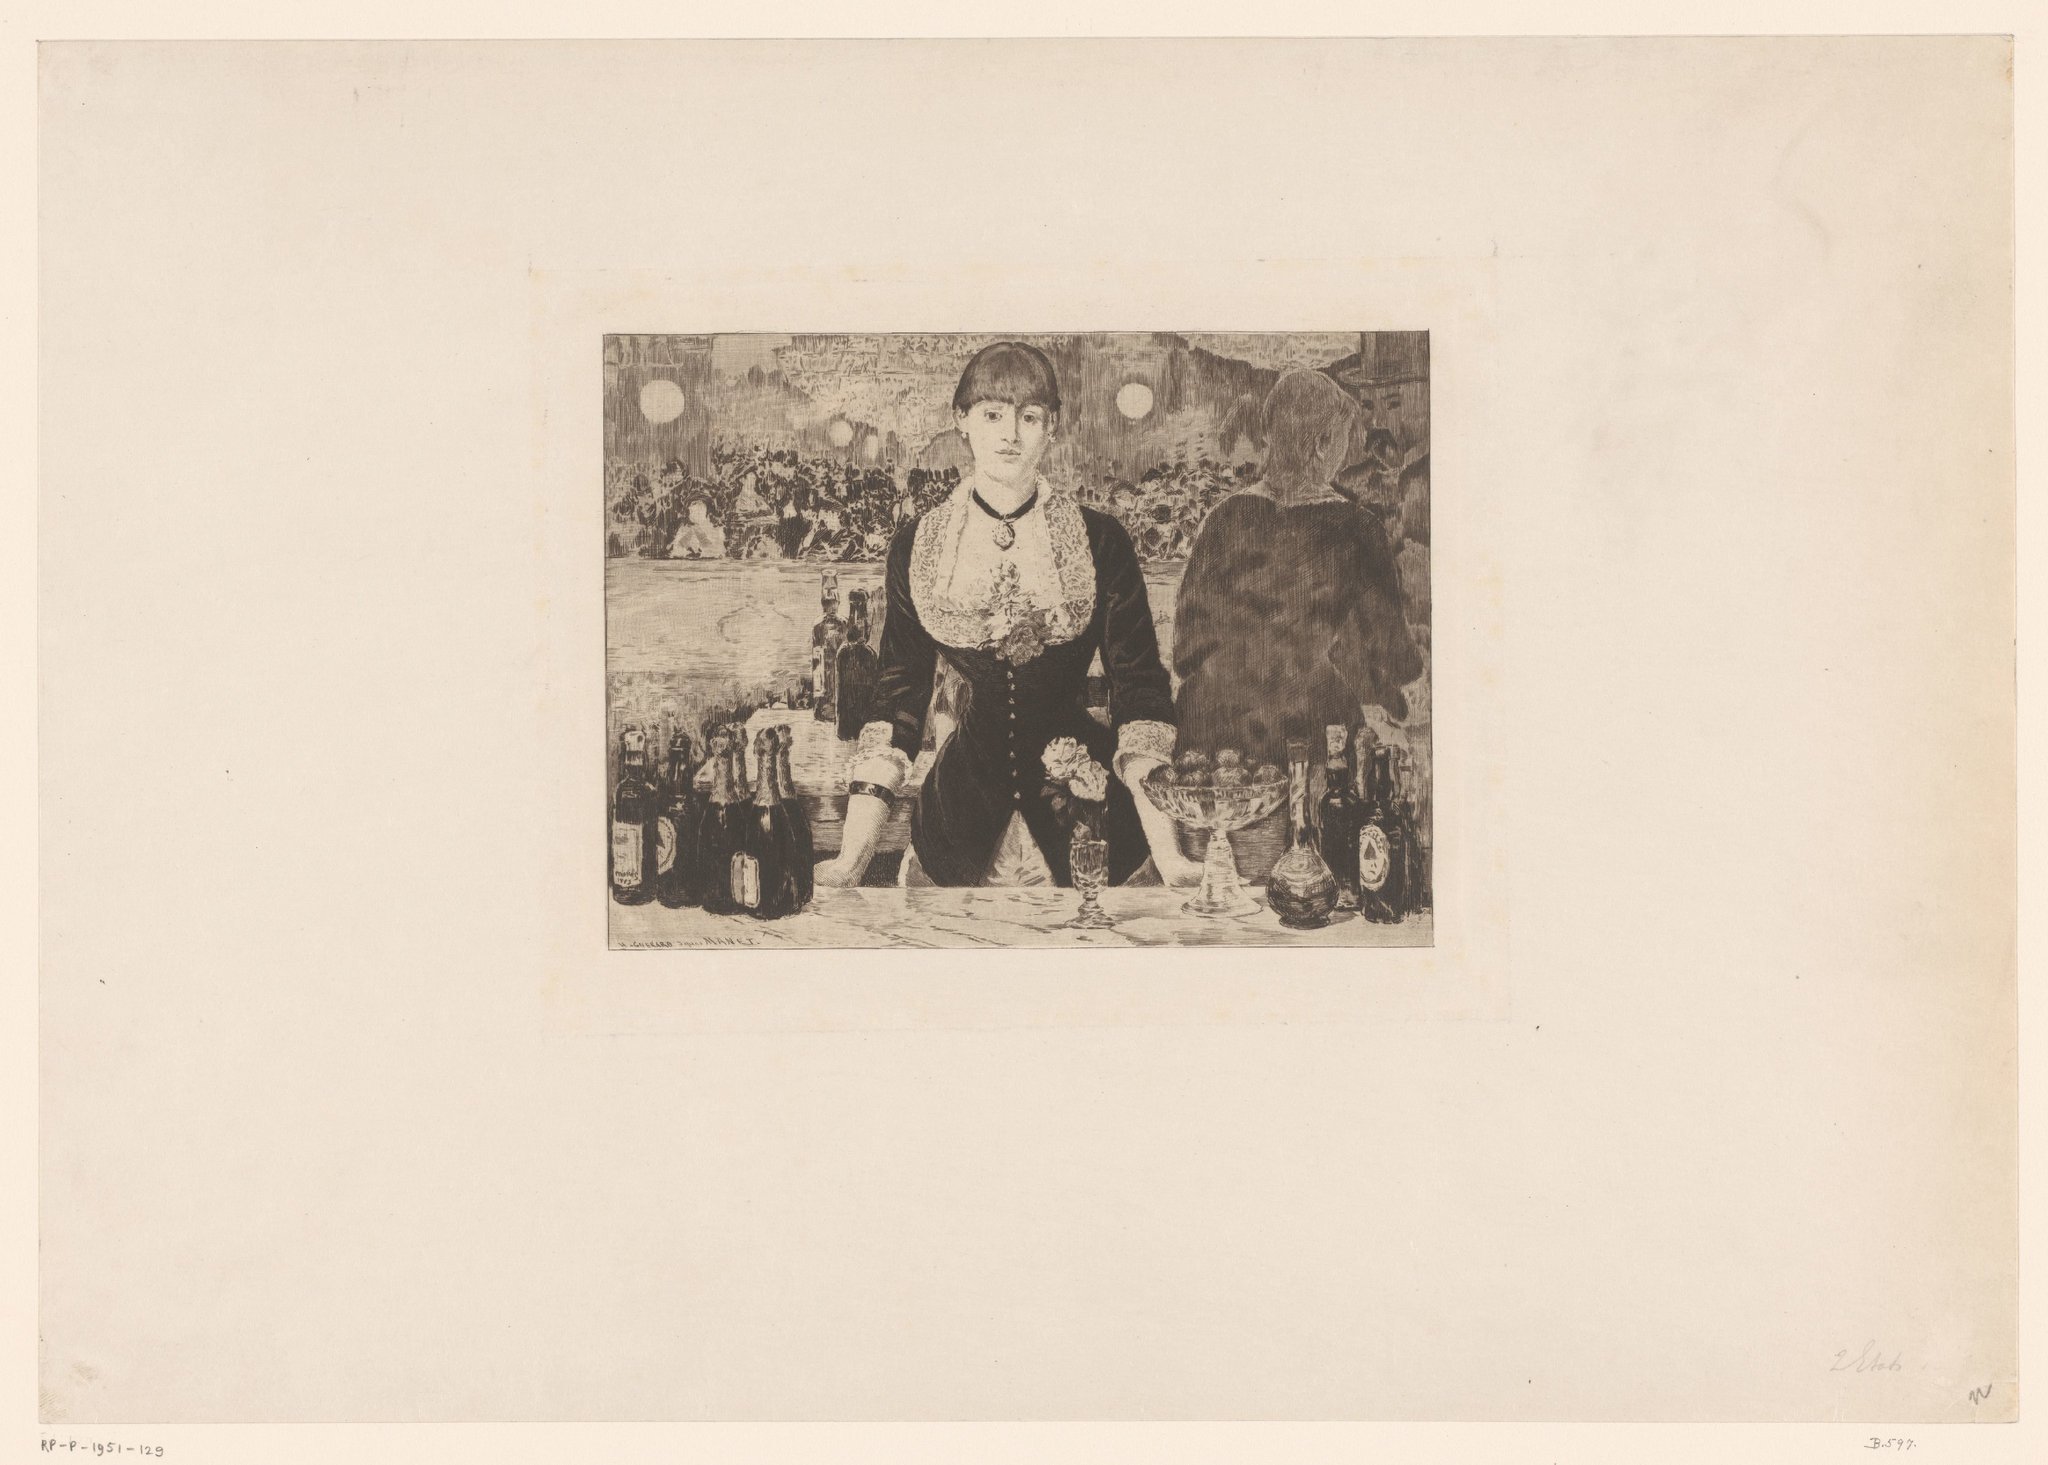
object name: print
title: Bar in de Folies-Bergère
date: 1882-1897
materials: paper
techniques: etching, roulette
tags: inn, coffee-house, public house, etc. (+ waiter, waitress, etc.), paris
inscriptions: collector's mark: Lugt 2228